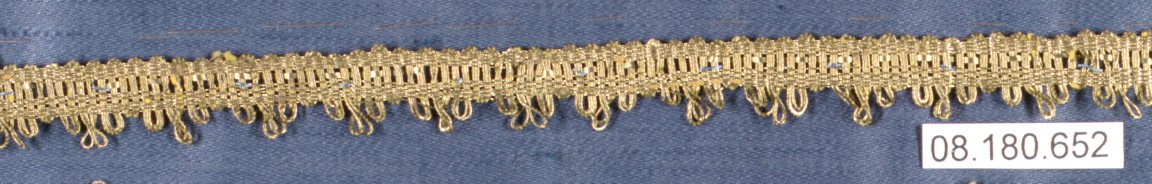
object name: gimp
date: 1601-1700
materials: metal thread